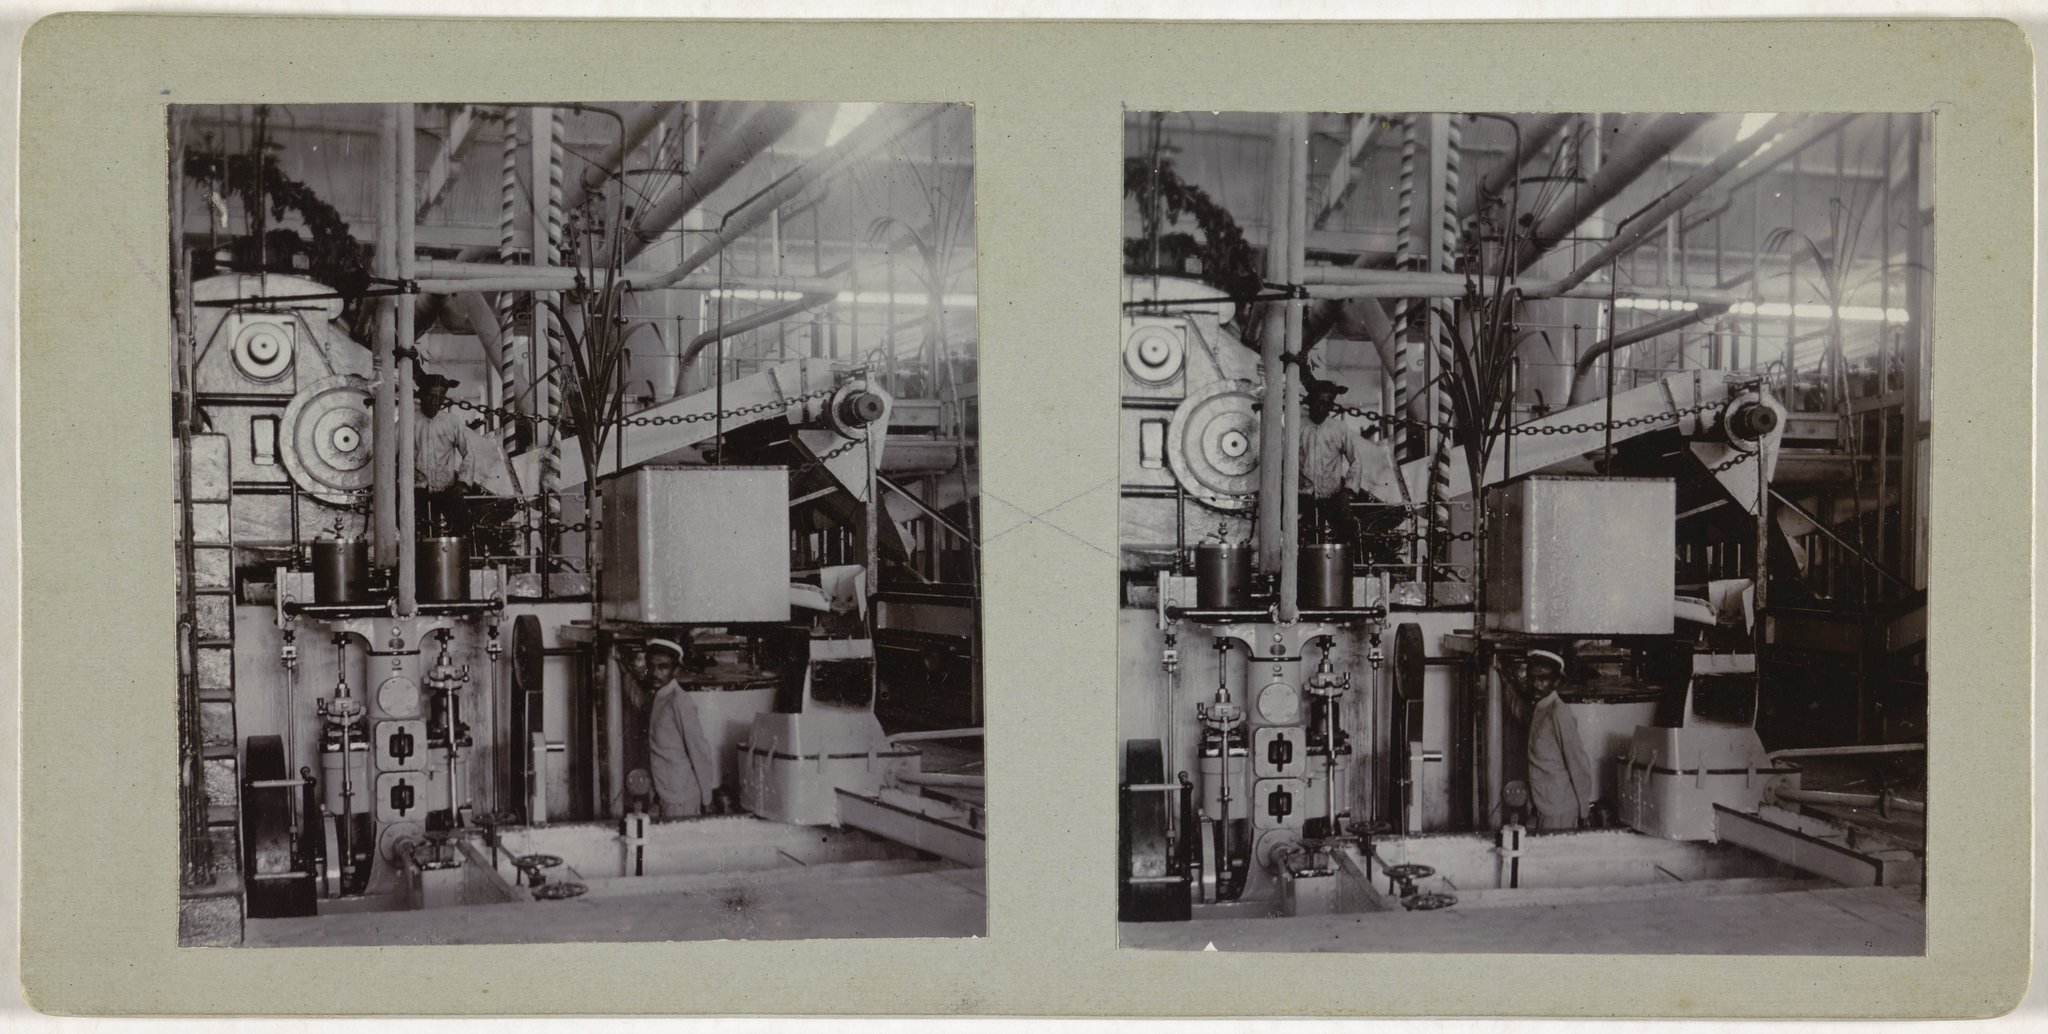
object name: stereograph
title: Twee mannen staand naast machines in suikerfabriek (?) Soemberkareng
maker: Anonymous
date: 1906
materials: cardboard, paper, photographic support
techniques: albumen print